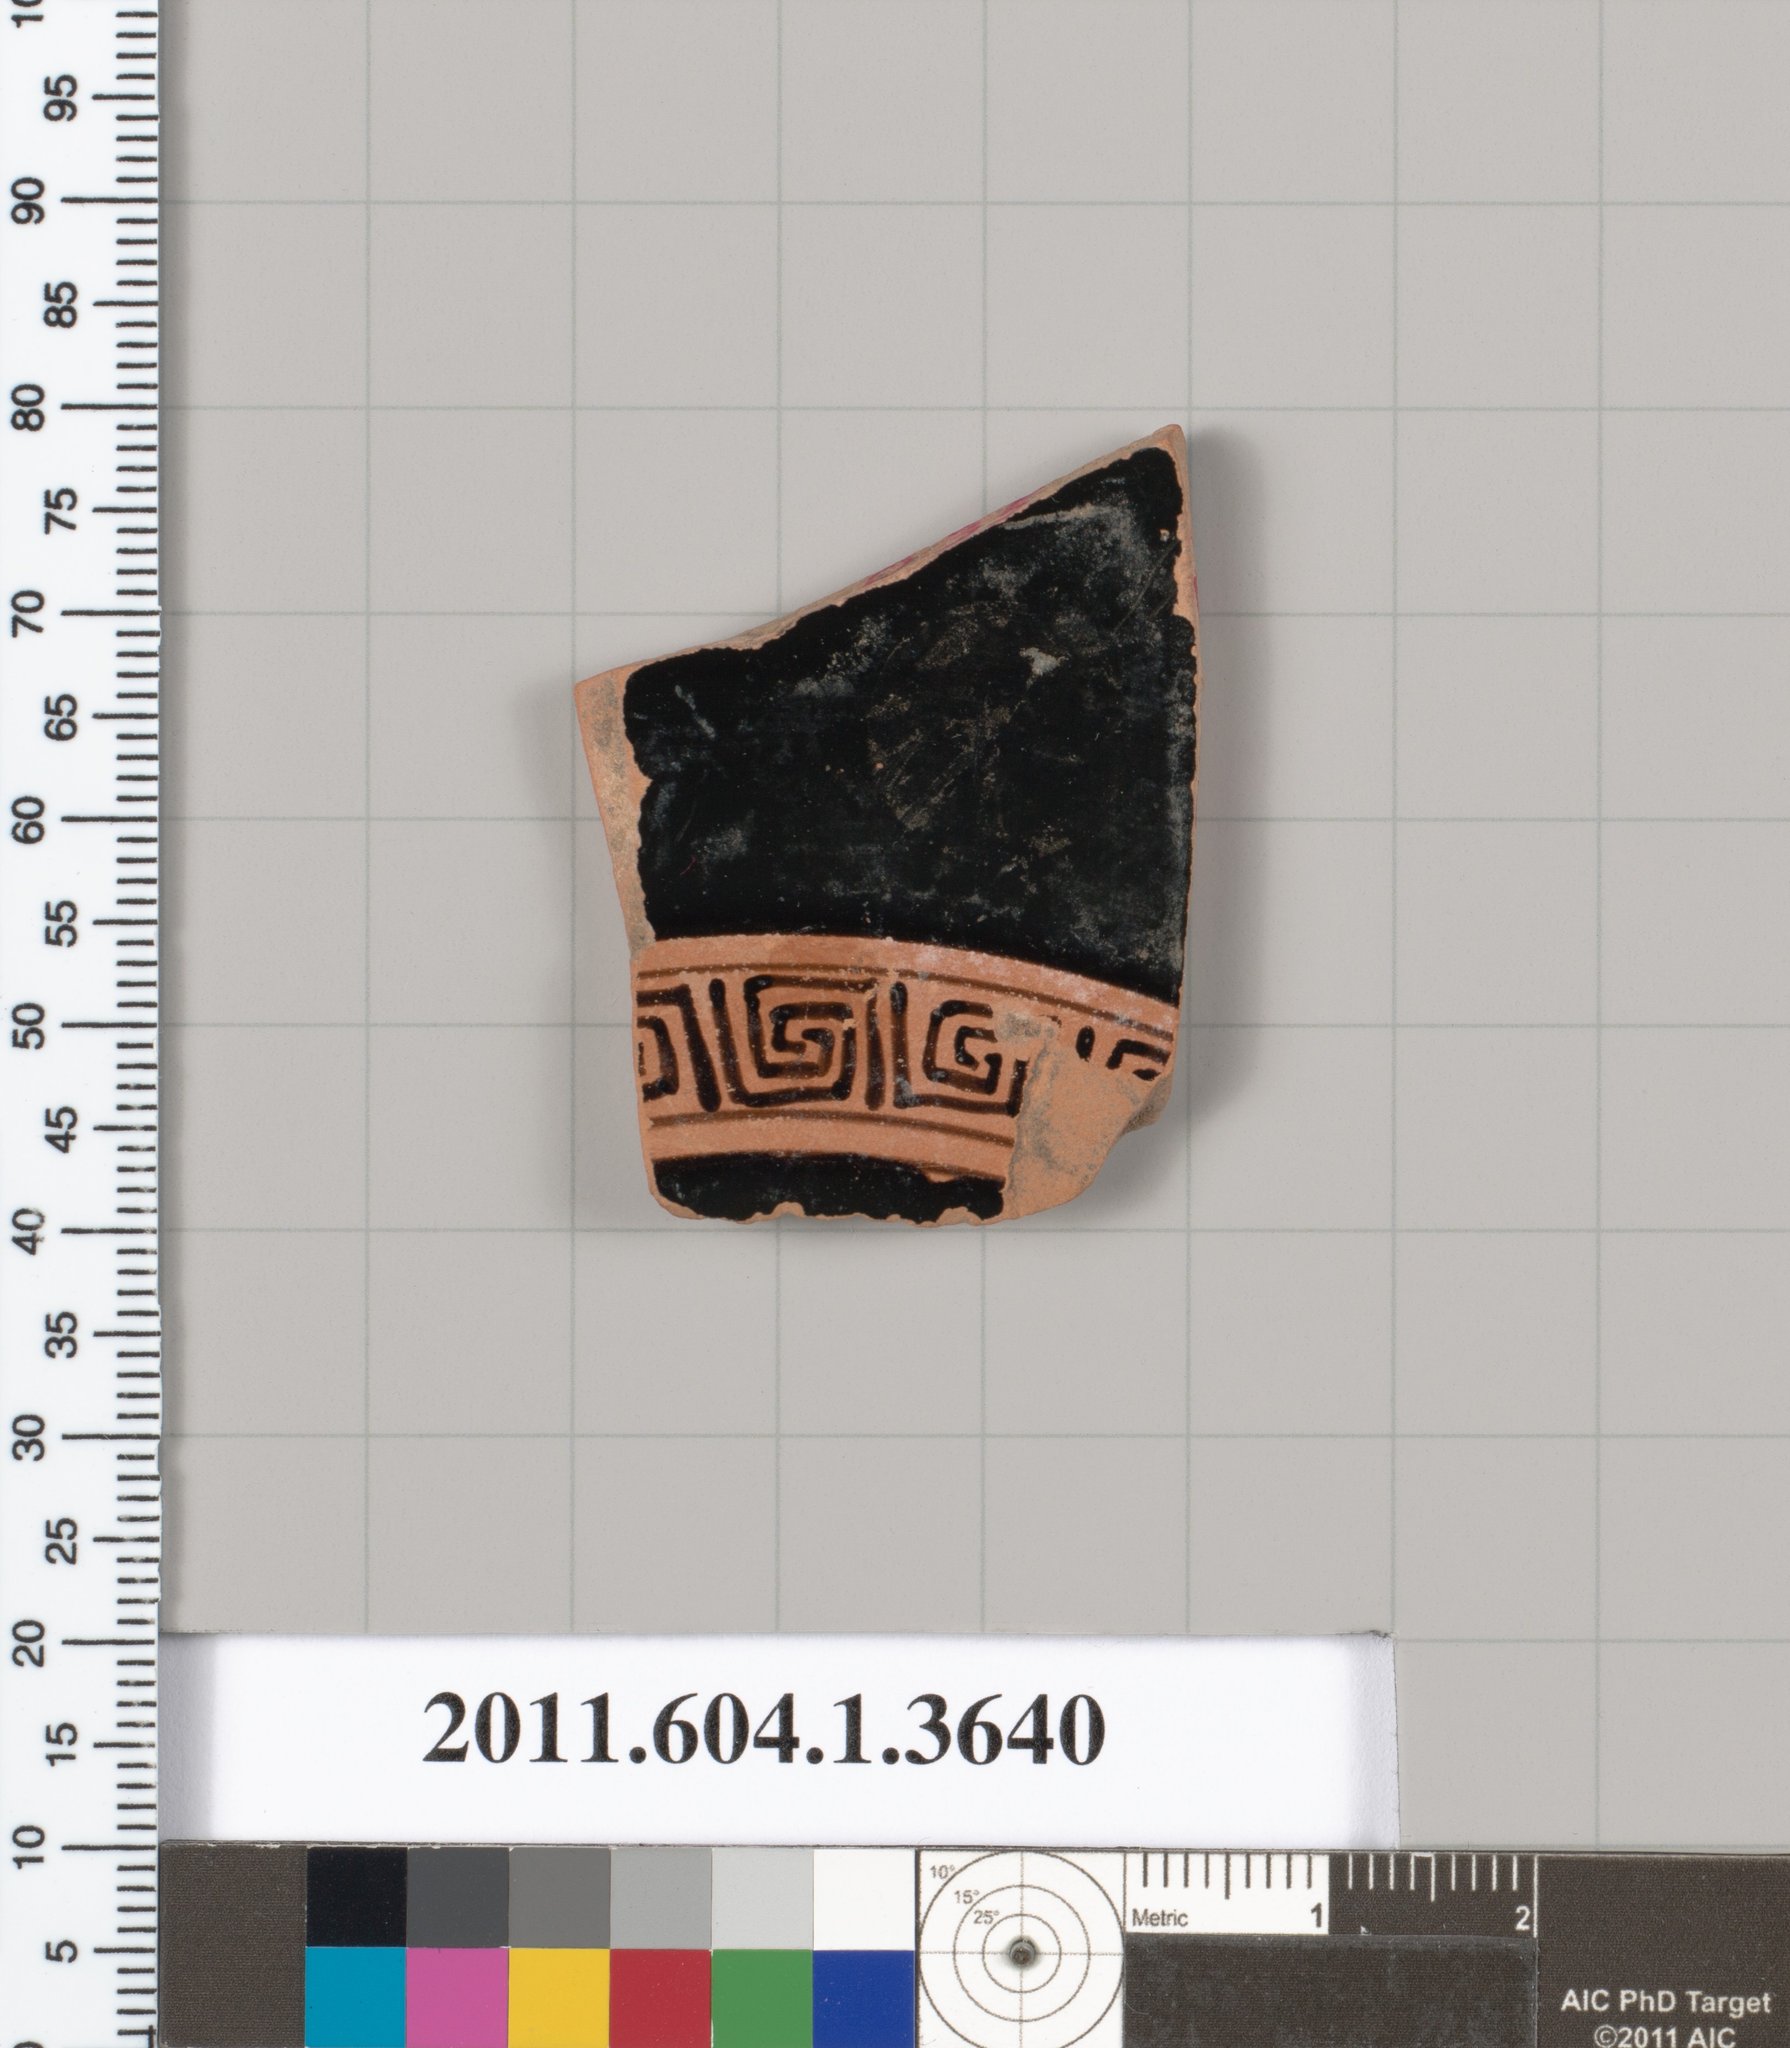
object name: kylix fragment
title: Terracotta fragment of a kylix (drinking cup)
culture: greek, attic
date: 475-451 BCE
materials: terracotta